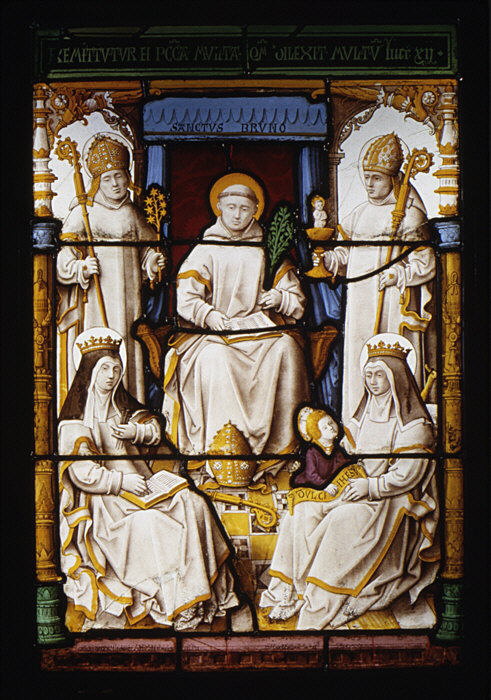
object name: panel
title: Saint Bruno, founder of the Carthusian Order, with other saints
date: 1501-1600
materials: glass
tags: men,women,croziers,saints